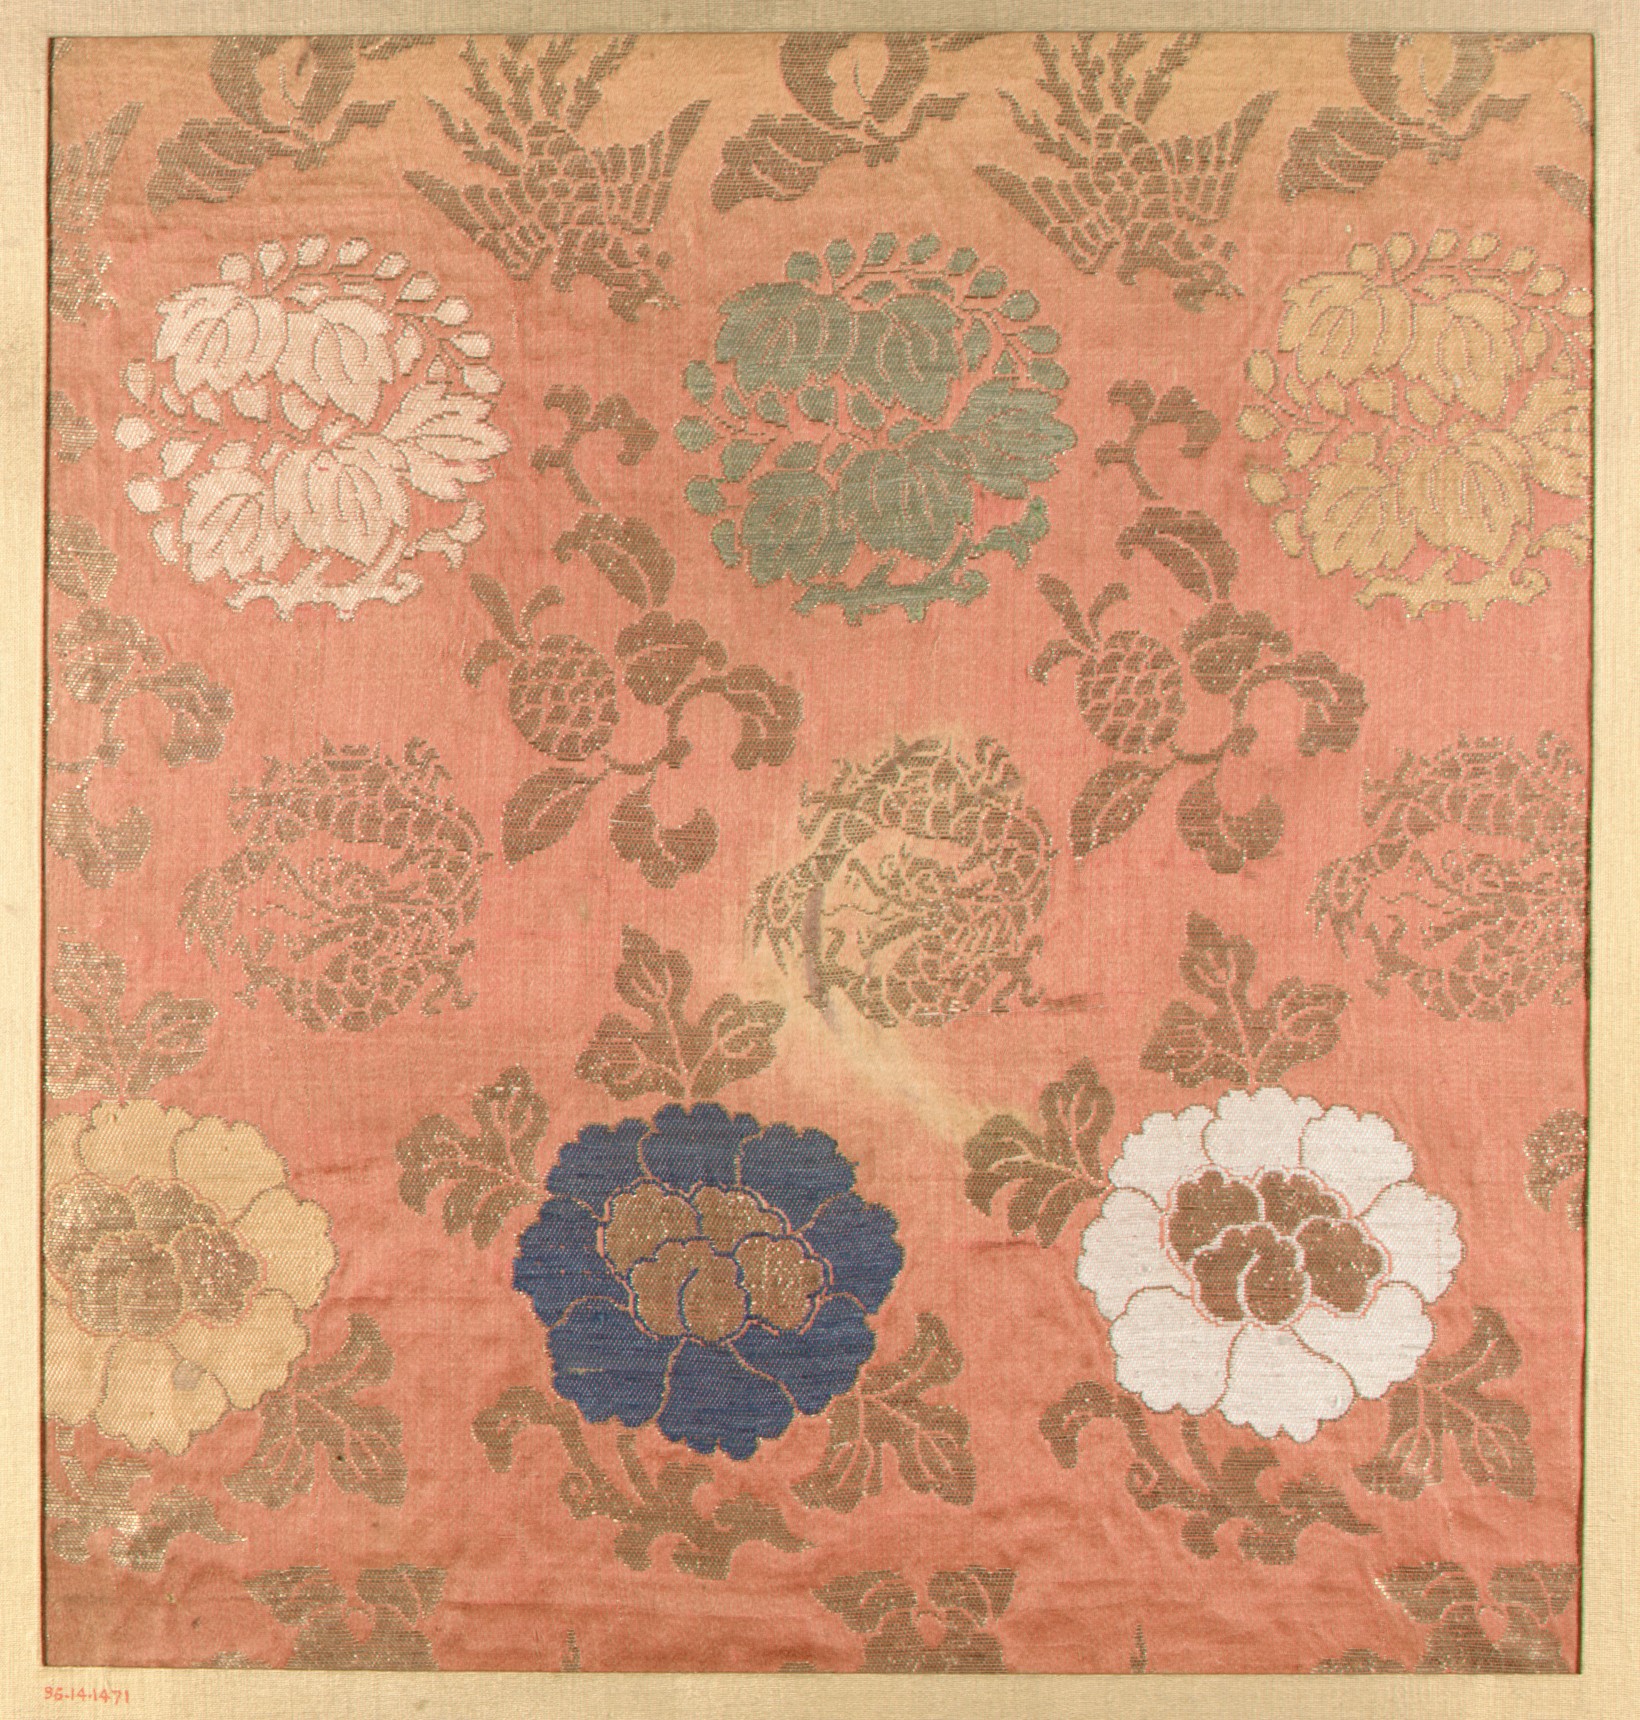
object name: piece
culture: japanese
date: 1701-1900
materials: silk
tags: flowers